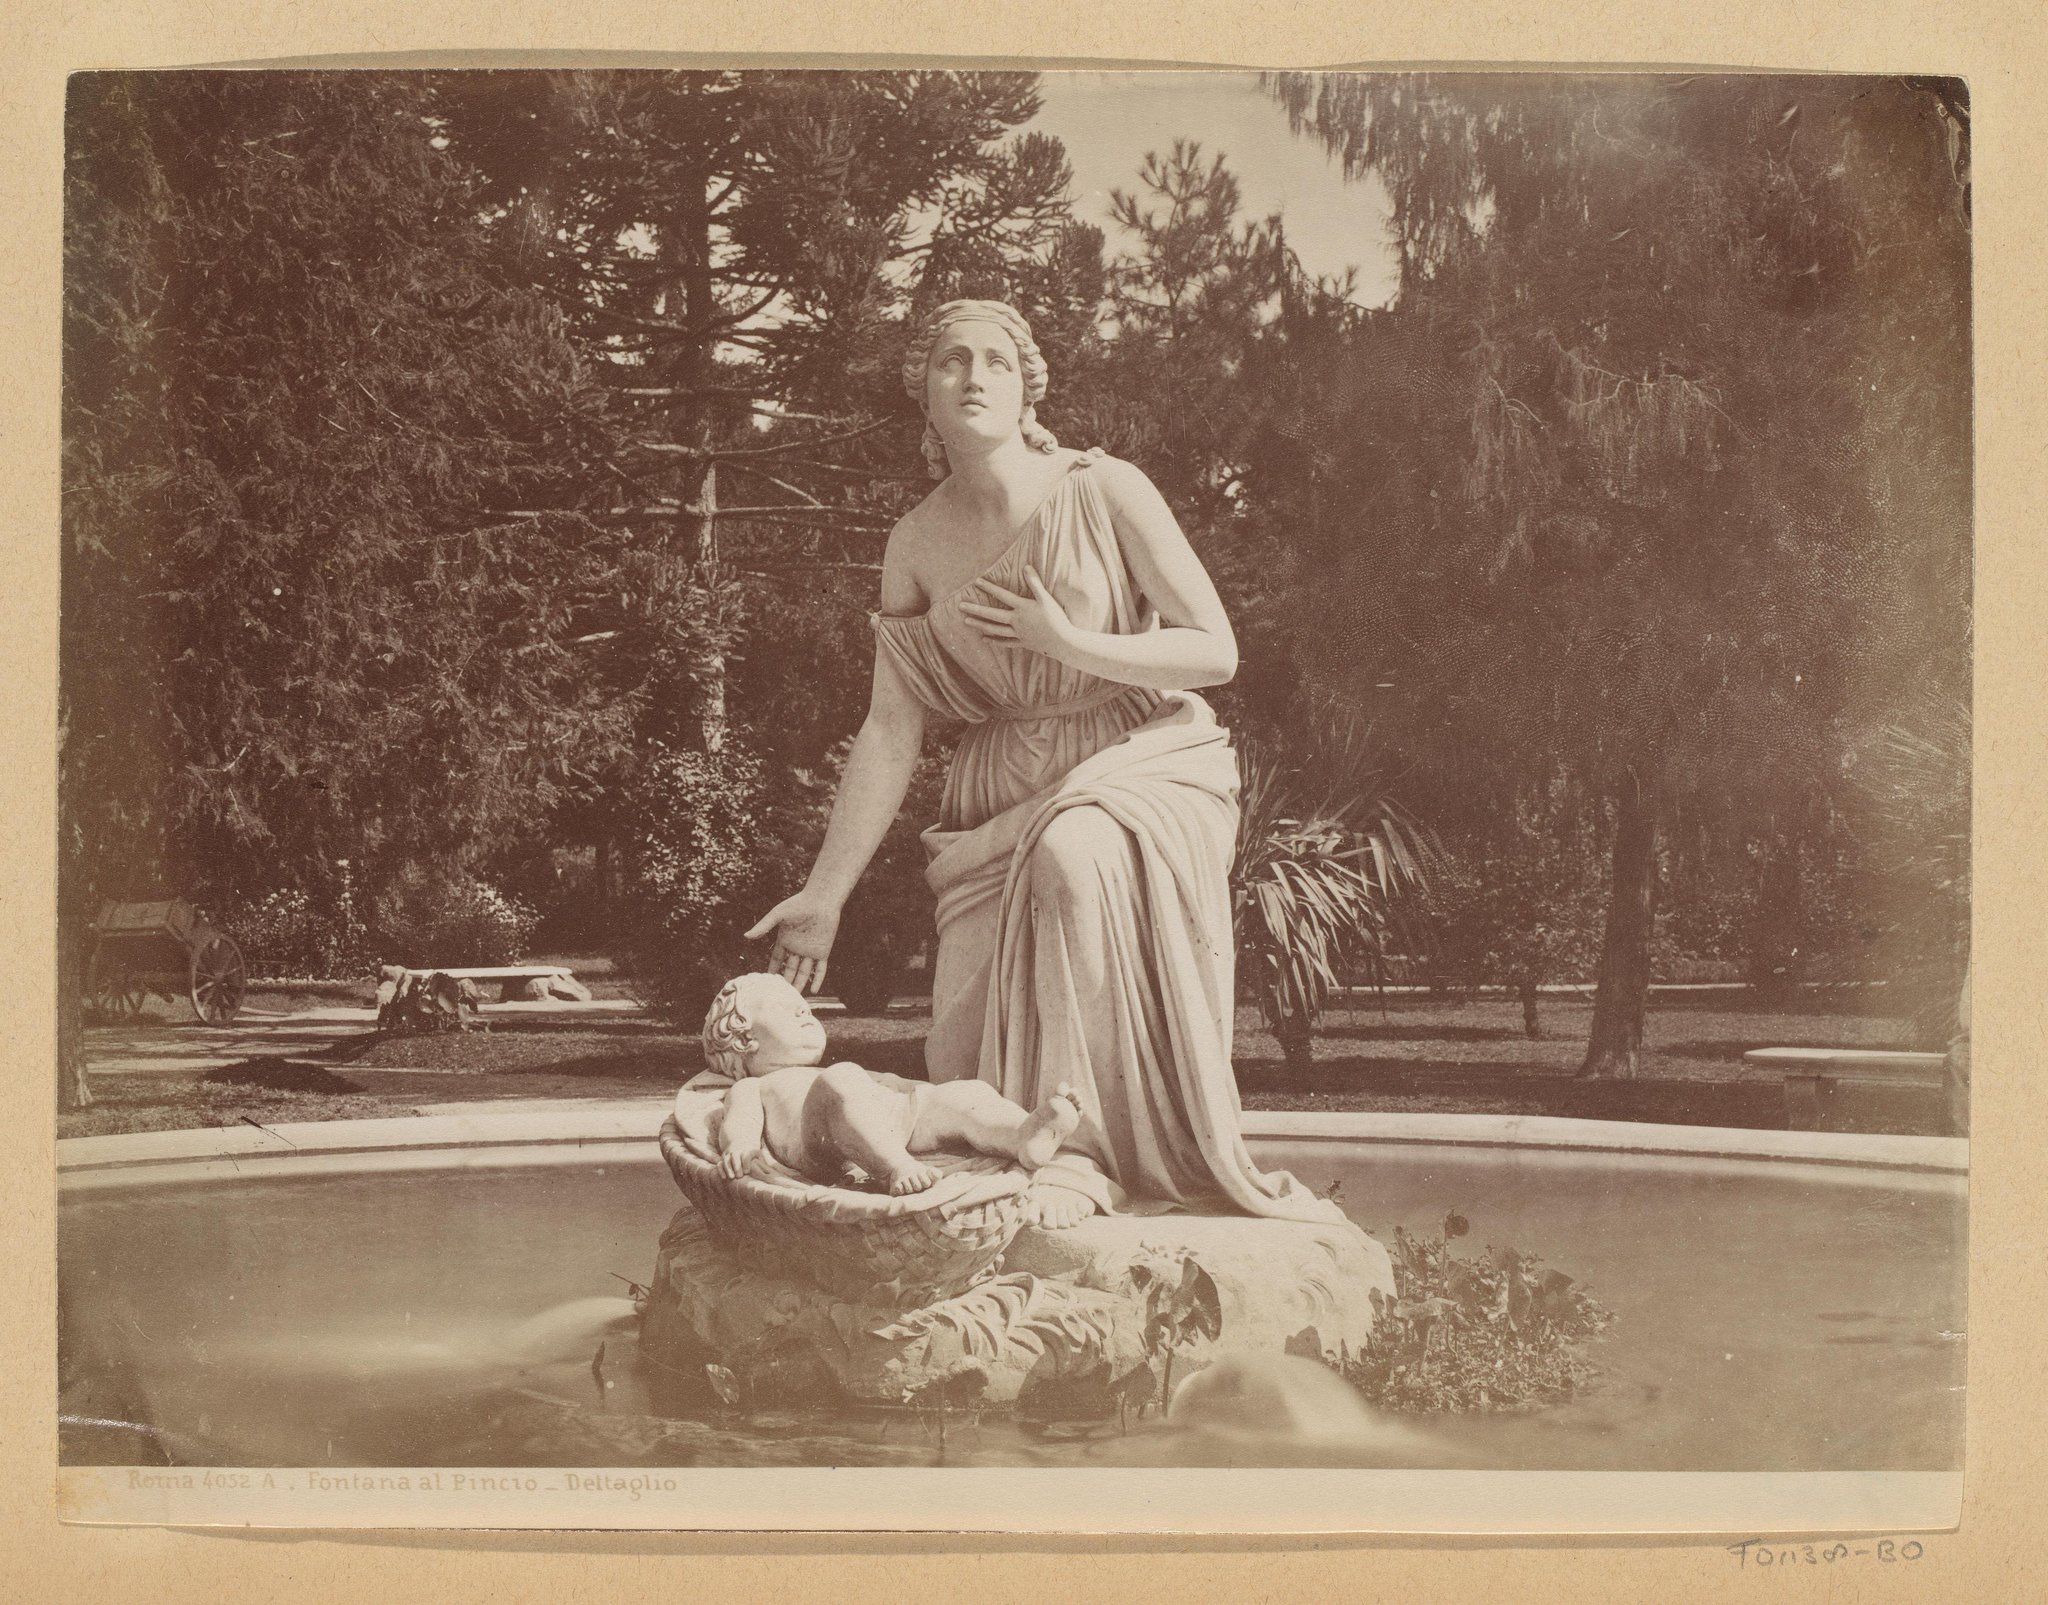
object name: photograph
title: Mozesfontein op de Pincio in Rome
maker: Anonymous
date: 1860-1900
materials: photographic support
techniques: albumen print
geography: pincio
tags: piece of sculpture, reproduction of a piece of sculpture, the finding of moses: pharaoh's daughter comes to bathe with her maidens in the river and discovers the child floating on the water, ornamental fountain (+ city(-scape) with figures, staffage)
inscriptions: number: ‘4052 A’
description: Onderdeel van Reisalbum met opnames van kunstwerken en bezienswaardigheden in Italië, Griekenland en Frankrijk.